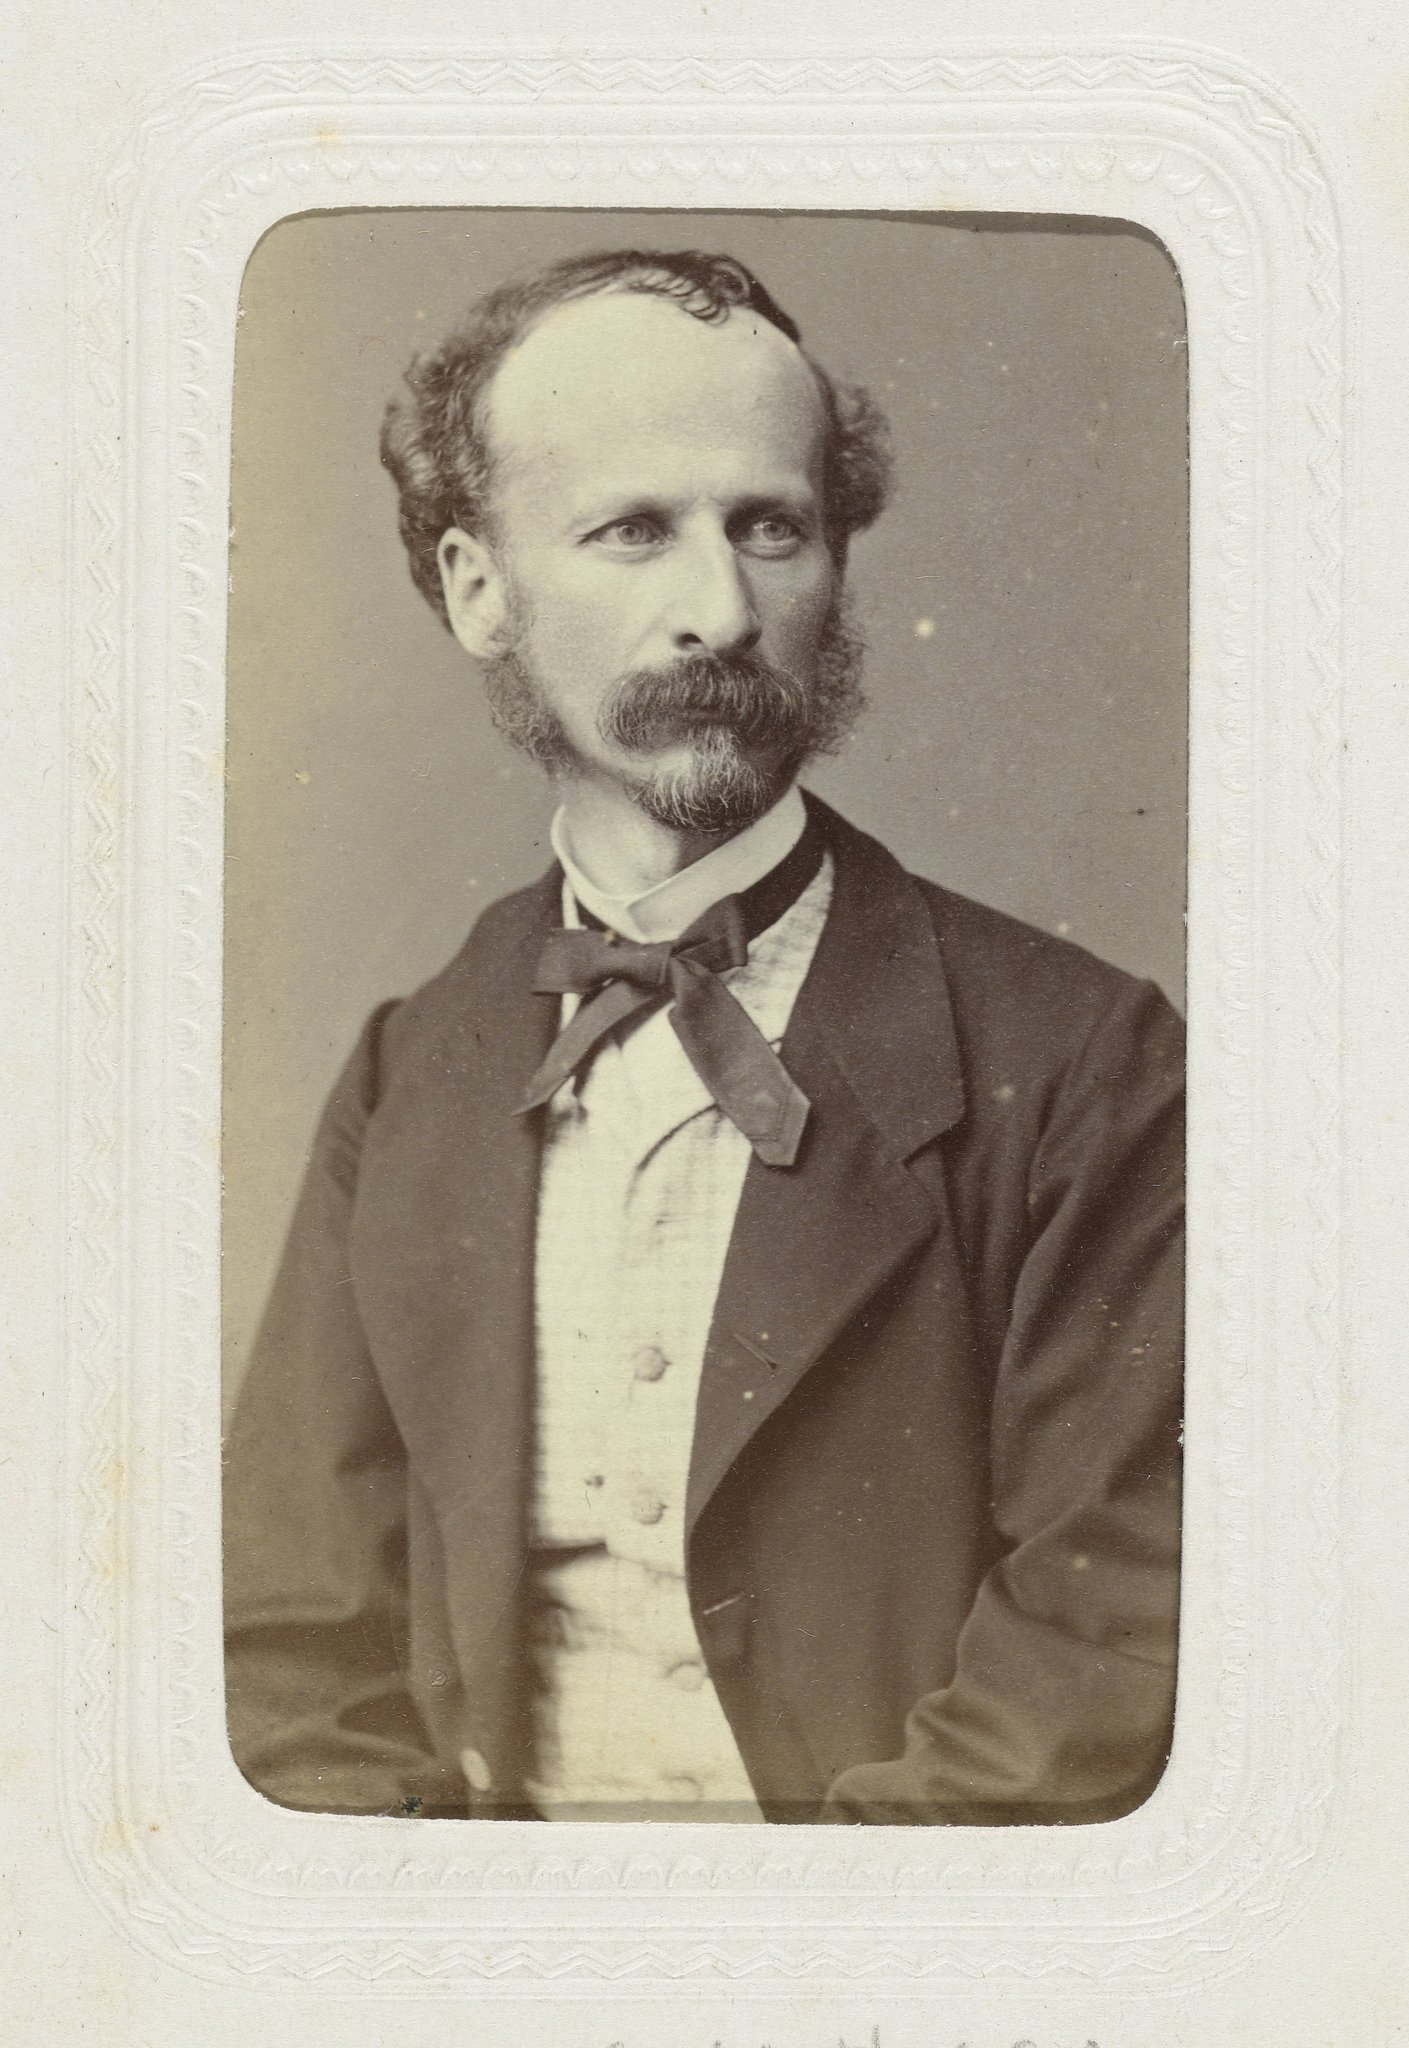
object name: carte de visite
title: Studioportret van een man met snor en bakkebaarden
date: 1863-1866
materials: cardboard, paper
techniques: albumen print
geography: istanbul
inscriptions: name: ‘Hubson’, name: ‘Abdullah freres’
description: De afgebeelde man is vermoedelijk de heer Lenz.